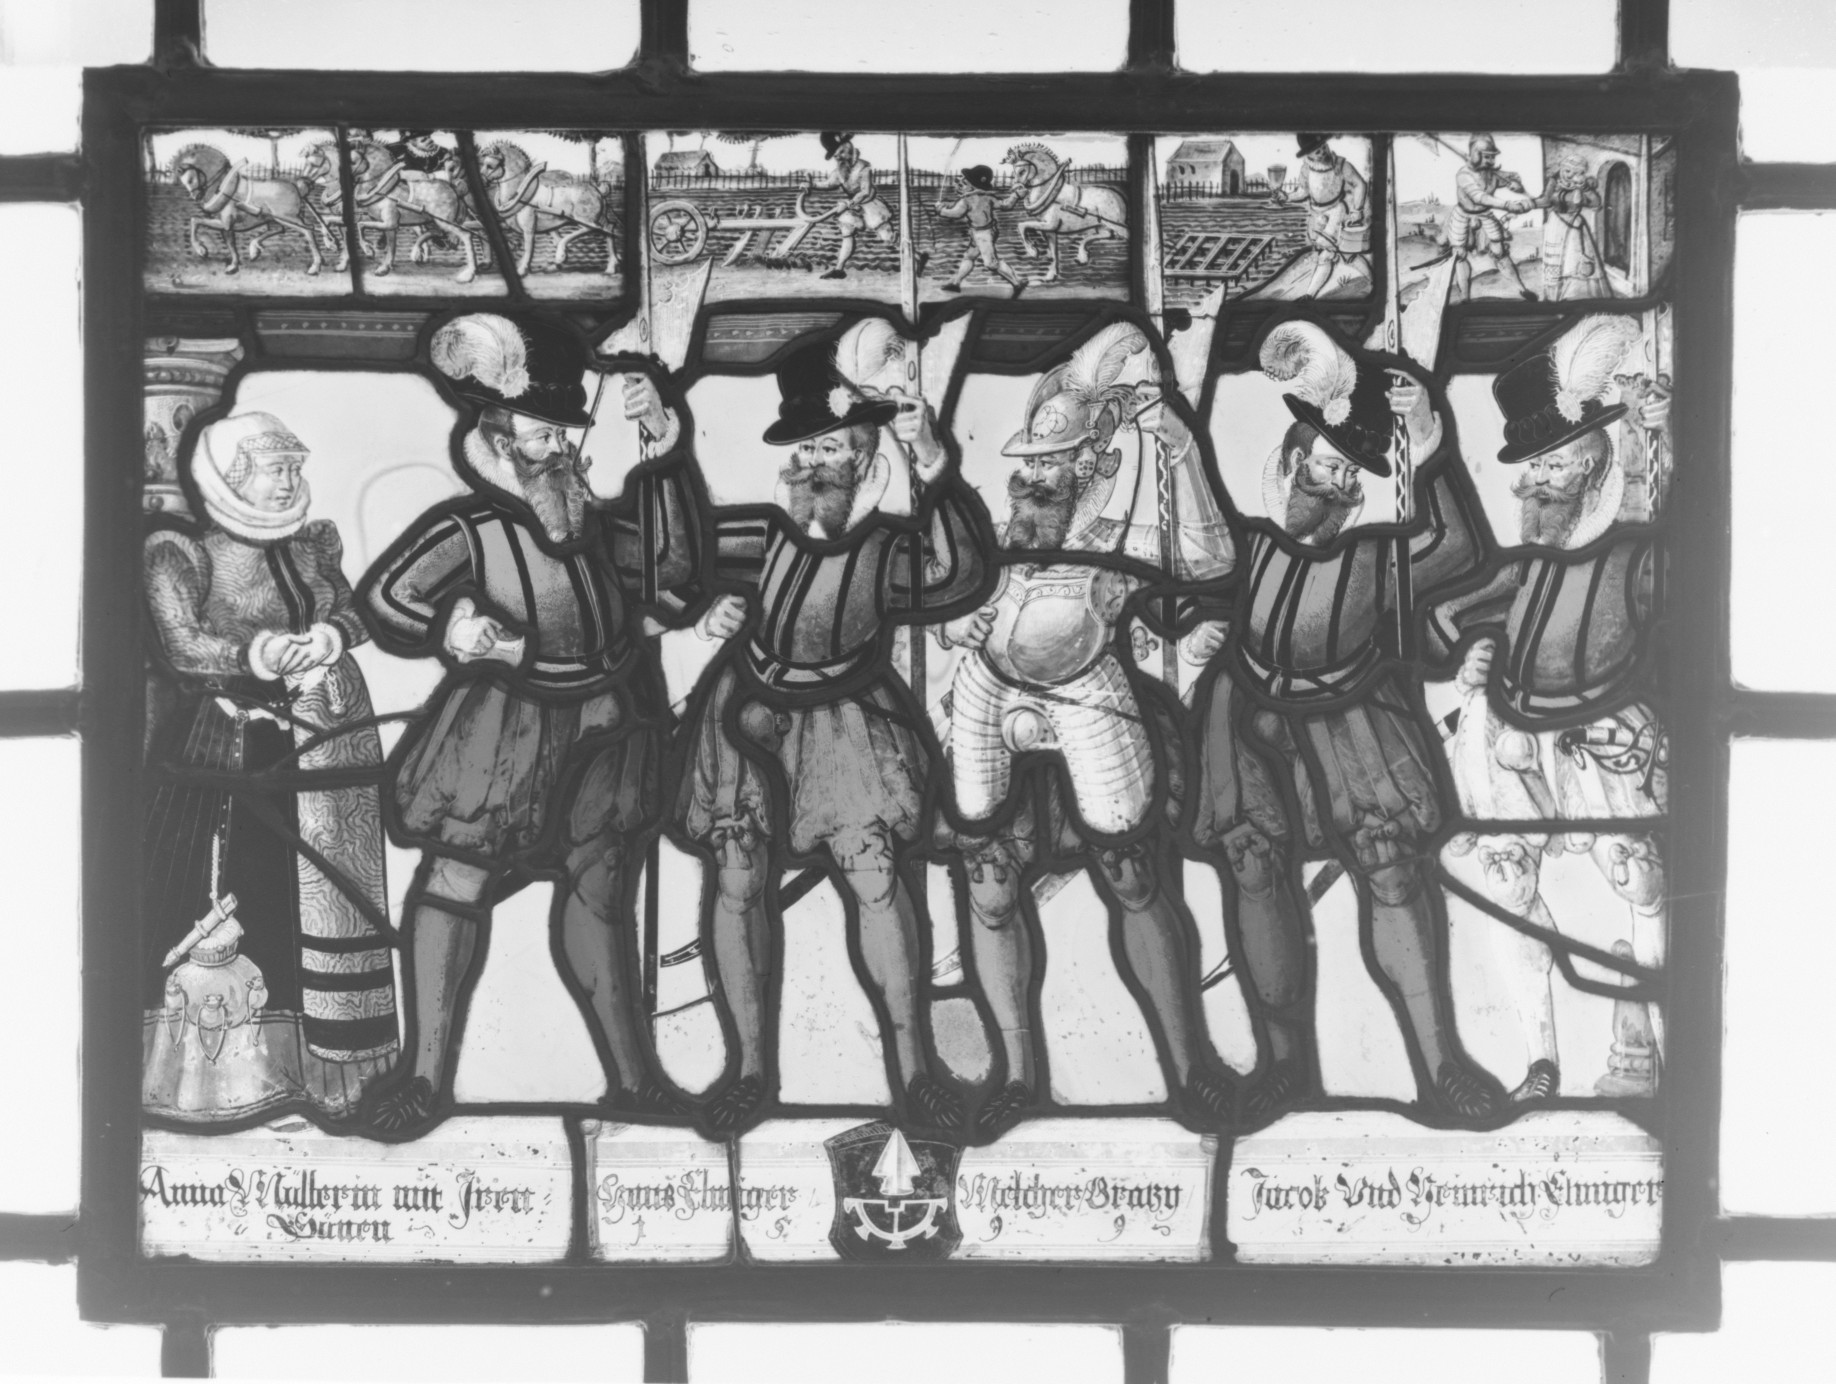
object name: panel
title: Anna Muller as donor with her five sons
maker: franz fallenter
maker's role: artist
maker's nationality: german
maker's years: 1550-1616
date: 1599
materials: glass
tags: men,women,horses